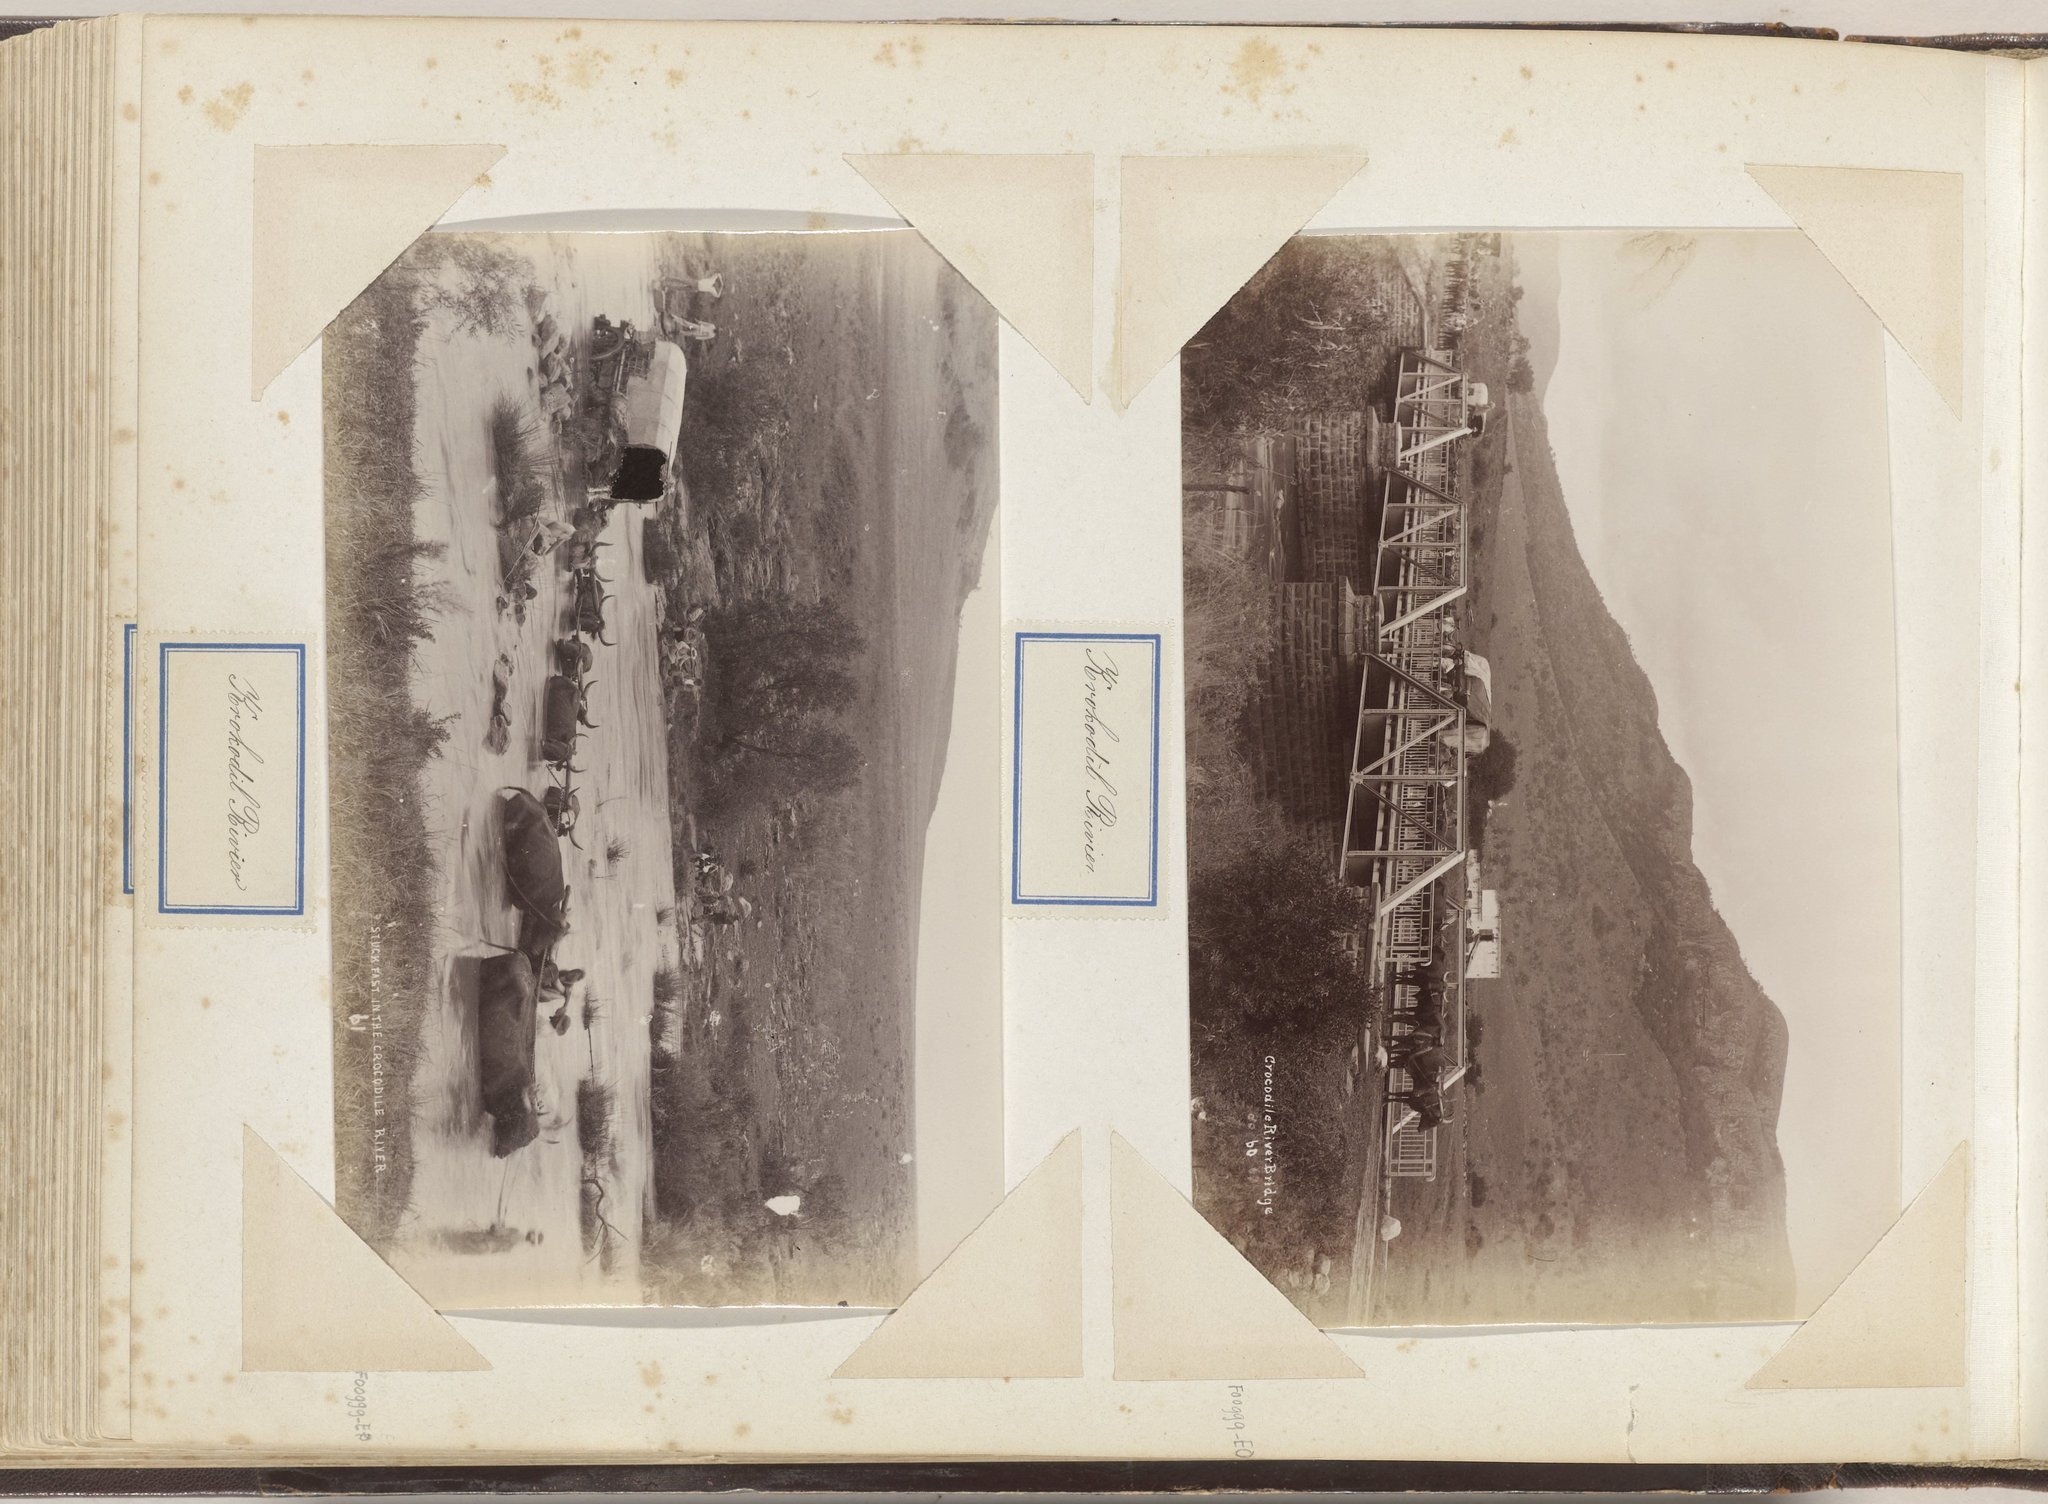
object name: photograph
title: Ossenkar steekt de Krokodilrivier in Zuid-Afrika over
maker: Anonymous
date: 1896-1910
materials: paper, photographic support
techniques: albumen print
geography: south africa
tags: animal traction, animal-drawn vehicle (carriage etc.), river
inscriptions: negative number: ‘61’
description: Onderdeel van Album met 191 foto's van een reis naar en door Zuid-Afrika.